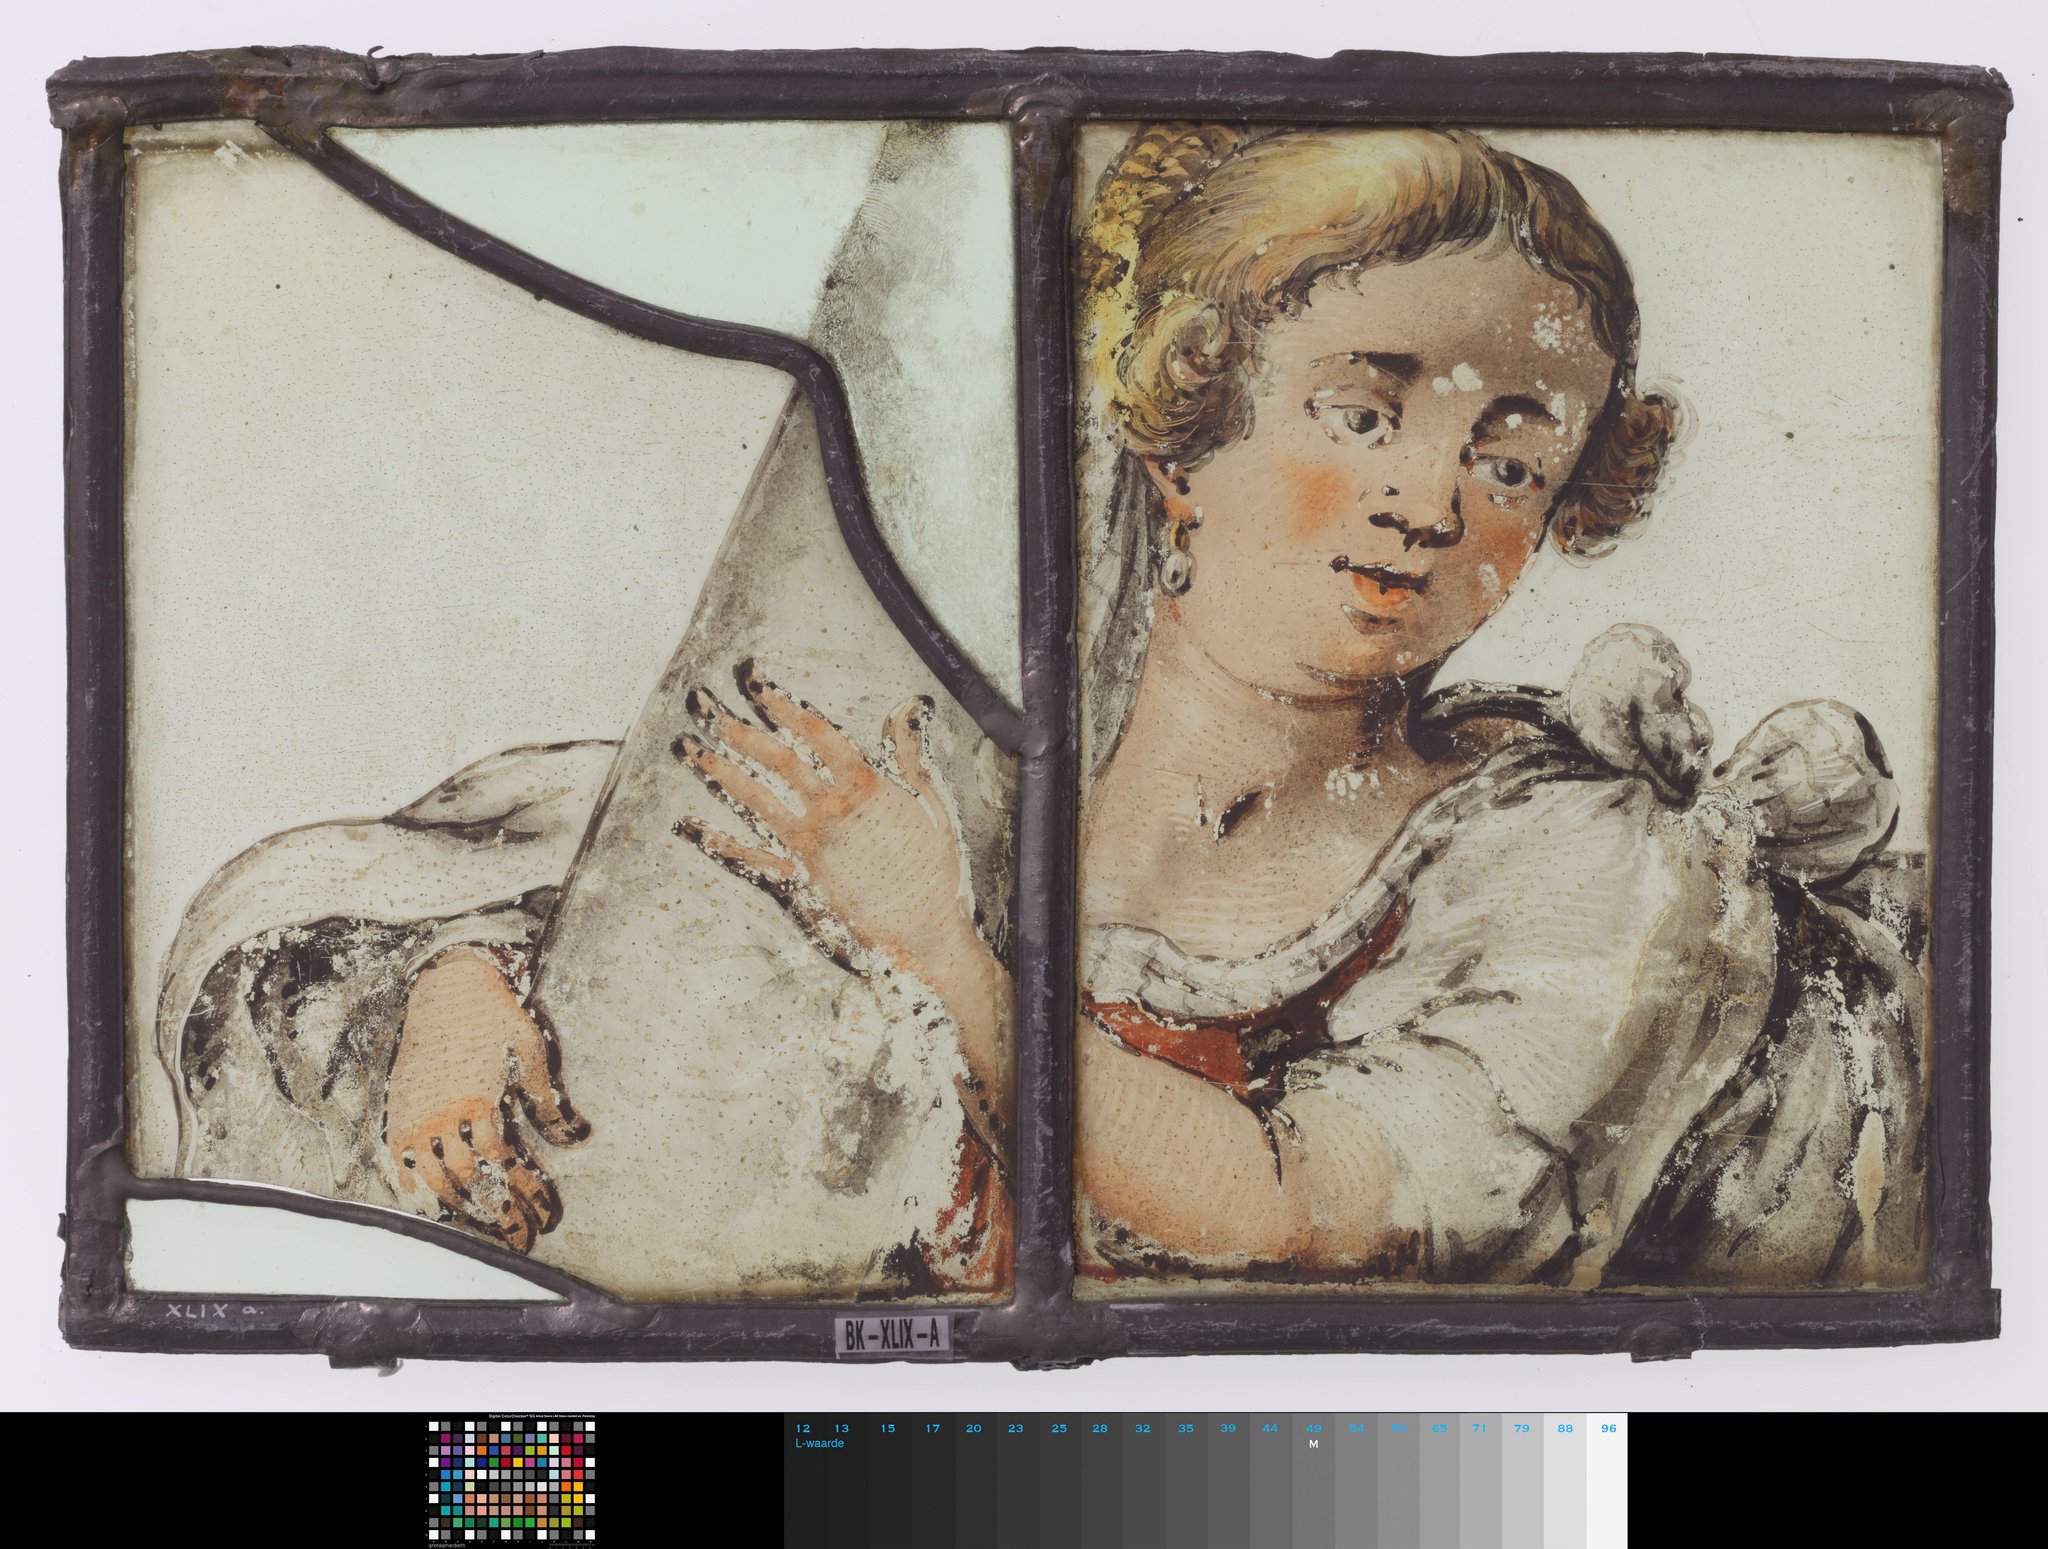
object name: light window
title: Ruit met hoofd, schouders en armen van een vrouwenfiguur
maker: Anonymous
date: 1600-1699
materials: glass, lead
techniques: leading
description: Twee ruiten met emailschildering afgebeeld: hoofd en schouders van een vrouw die een cilindervormig voorwerp draagt. Behoren tot groep inv. nrs. BK-XLIX-A t/m G.